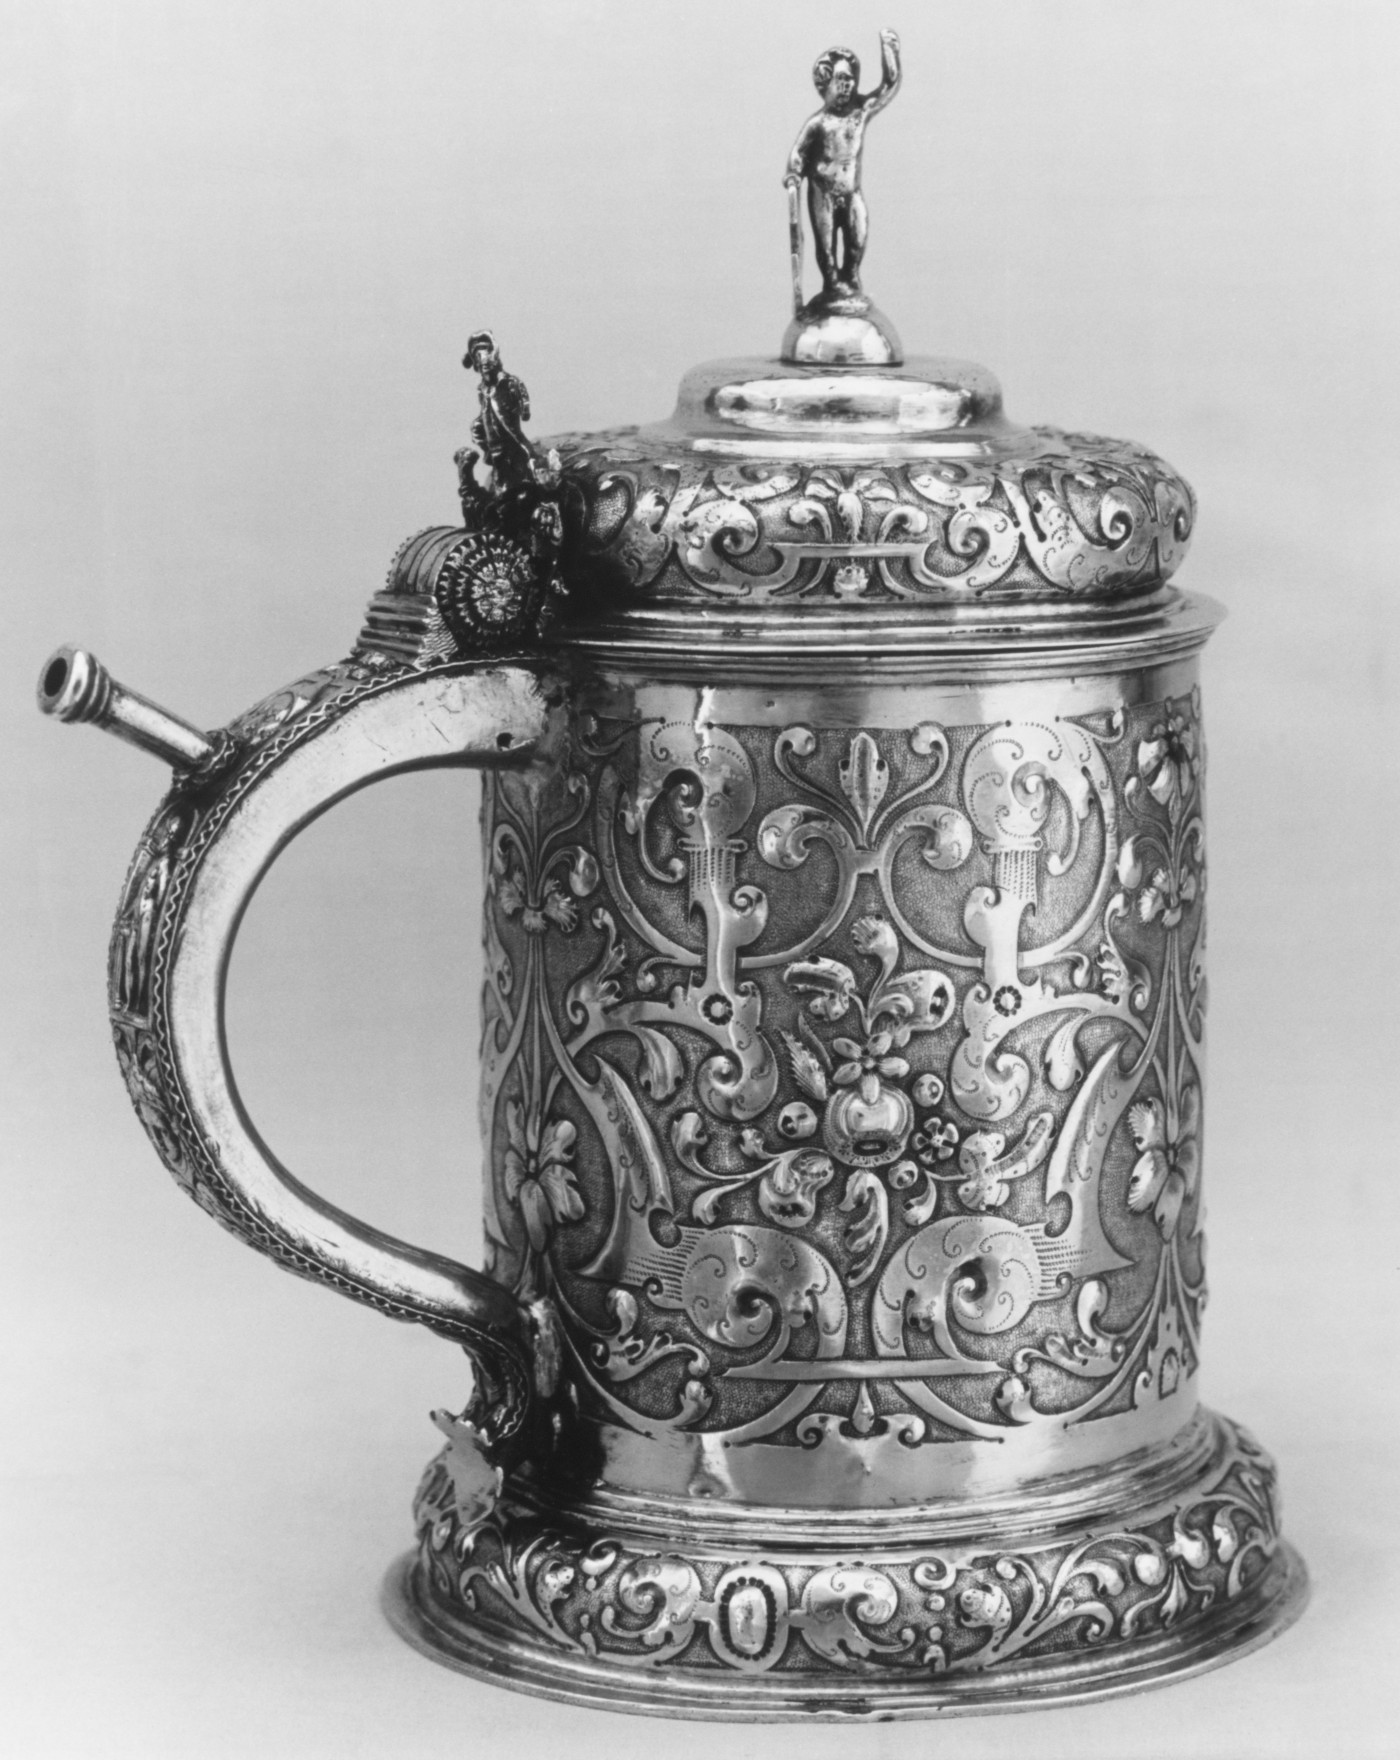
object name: tankard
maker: peter wiber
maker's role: silversmith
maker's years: 1541-1641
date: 1601-1633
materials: silver gilt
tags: human figures,flowers